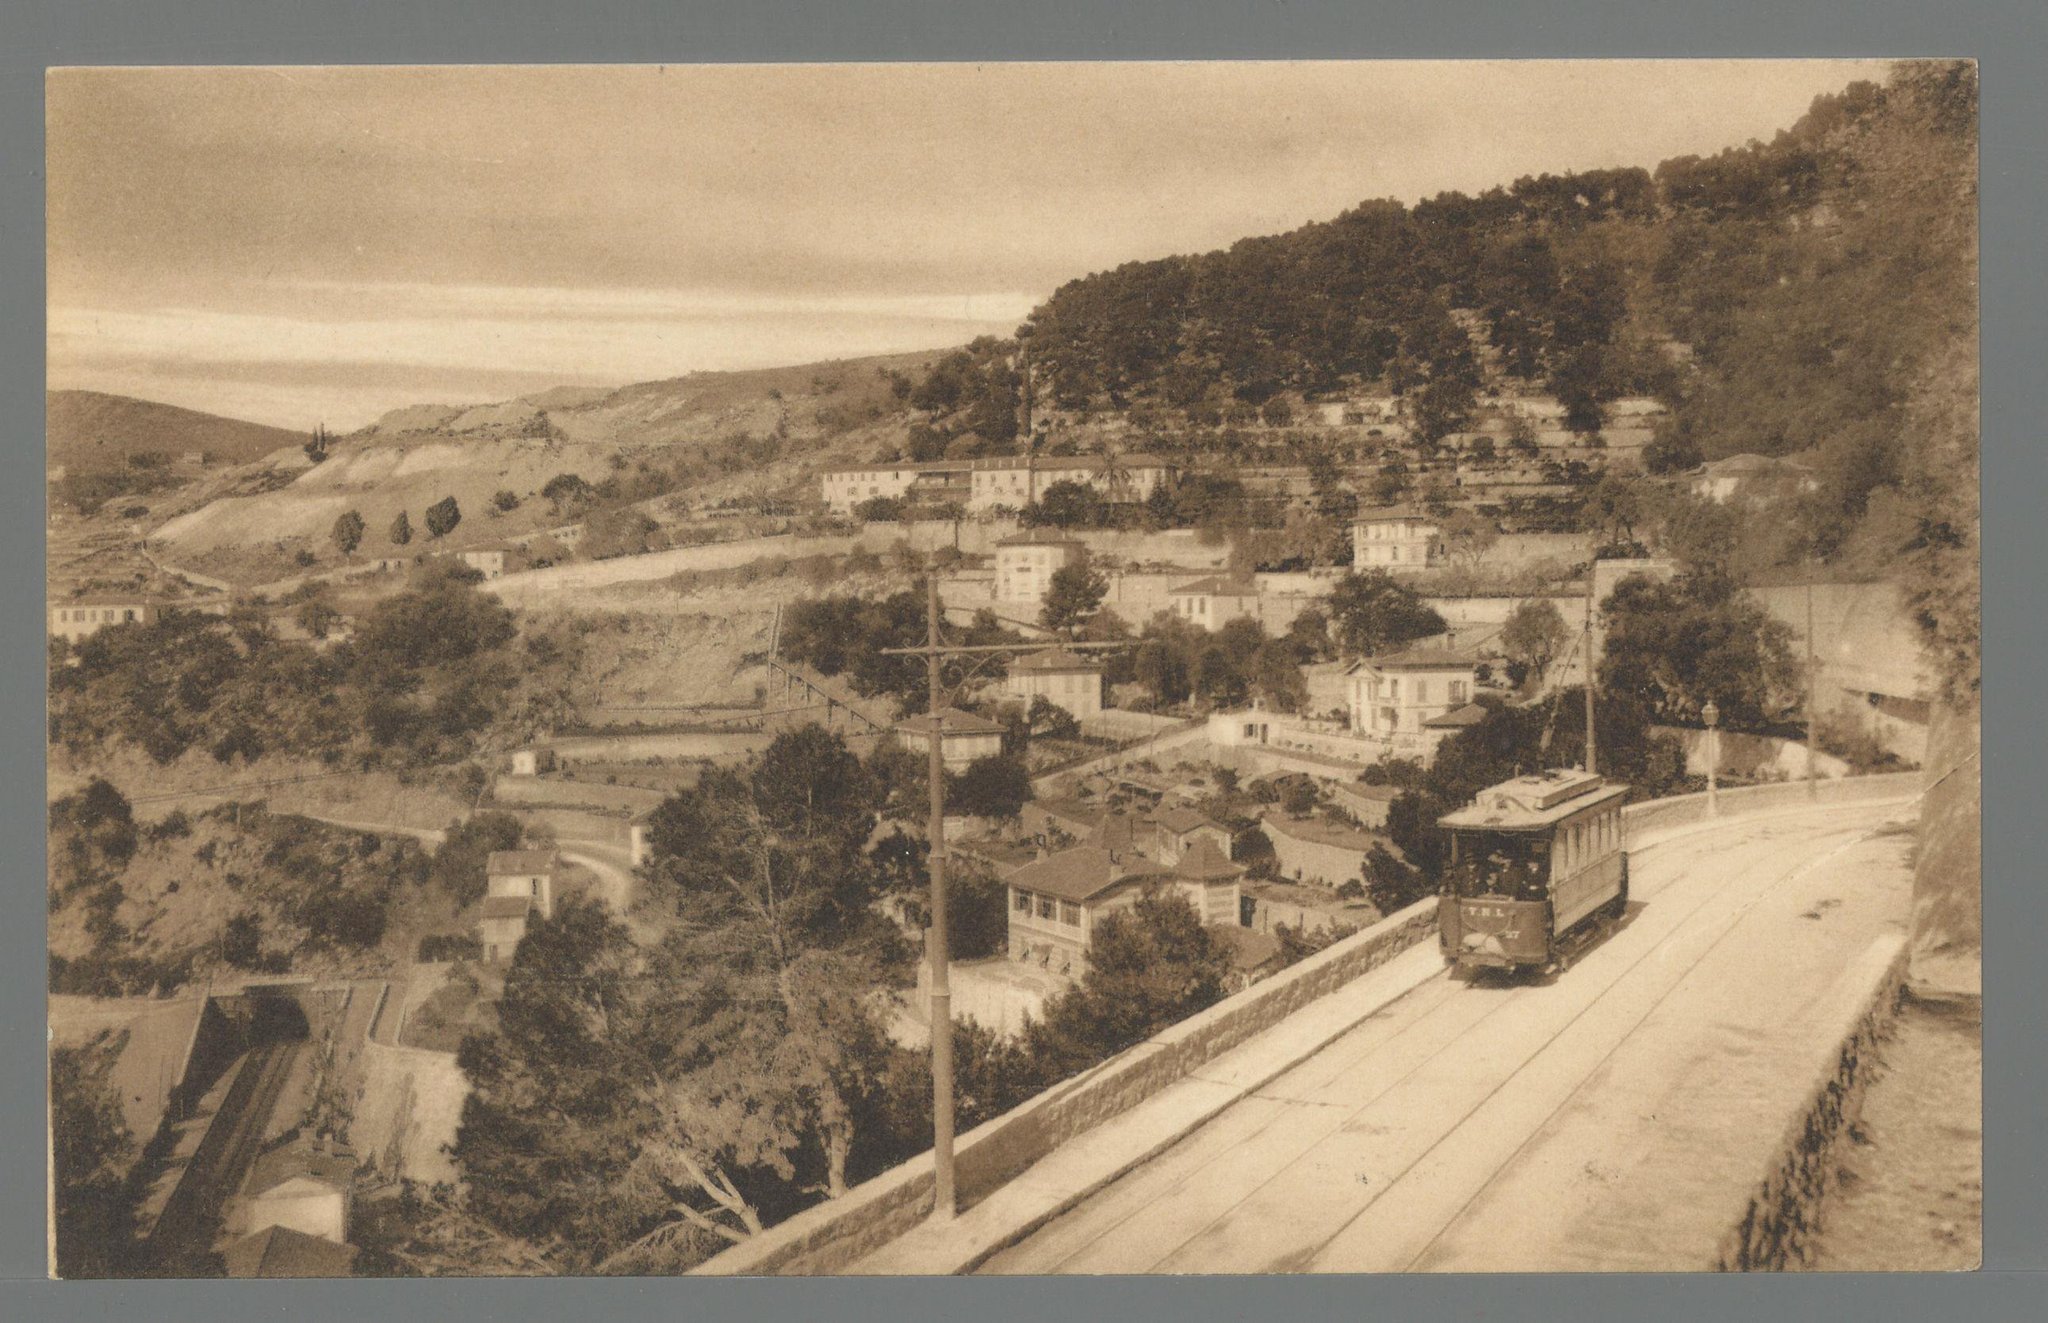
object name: ansichtkaart, prentbriefkaart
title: Route de Villefranche à Beaulieu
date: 1903-1909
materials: cardboard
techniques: photograph, writing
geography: paris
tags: tramway, tram, landscapes with waters, waterscapes, seascapes (in the temperate zone)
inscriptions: inscription: ‘22-1-'09’